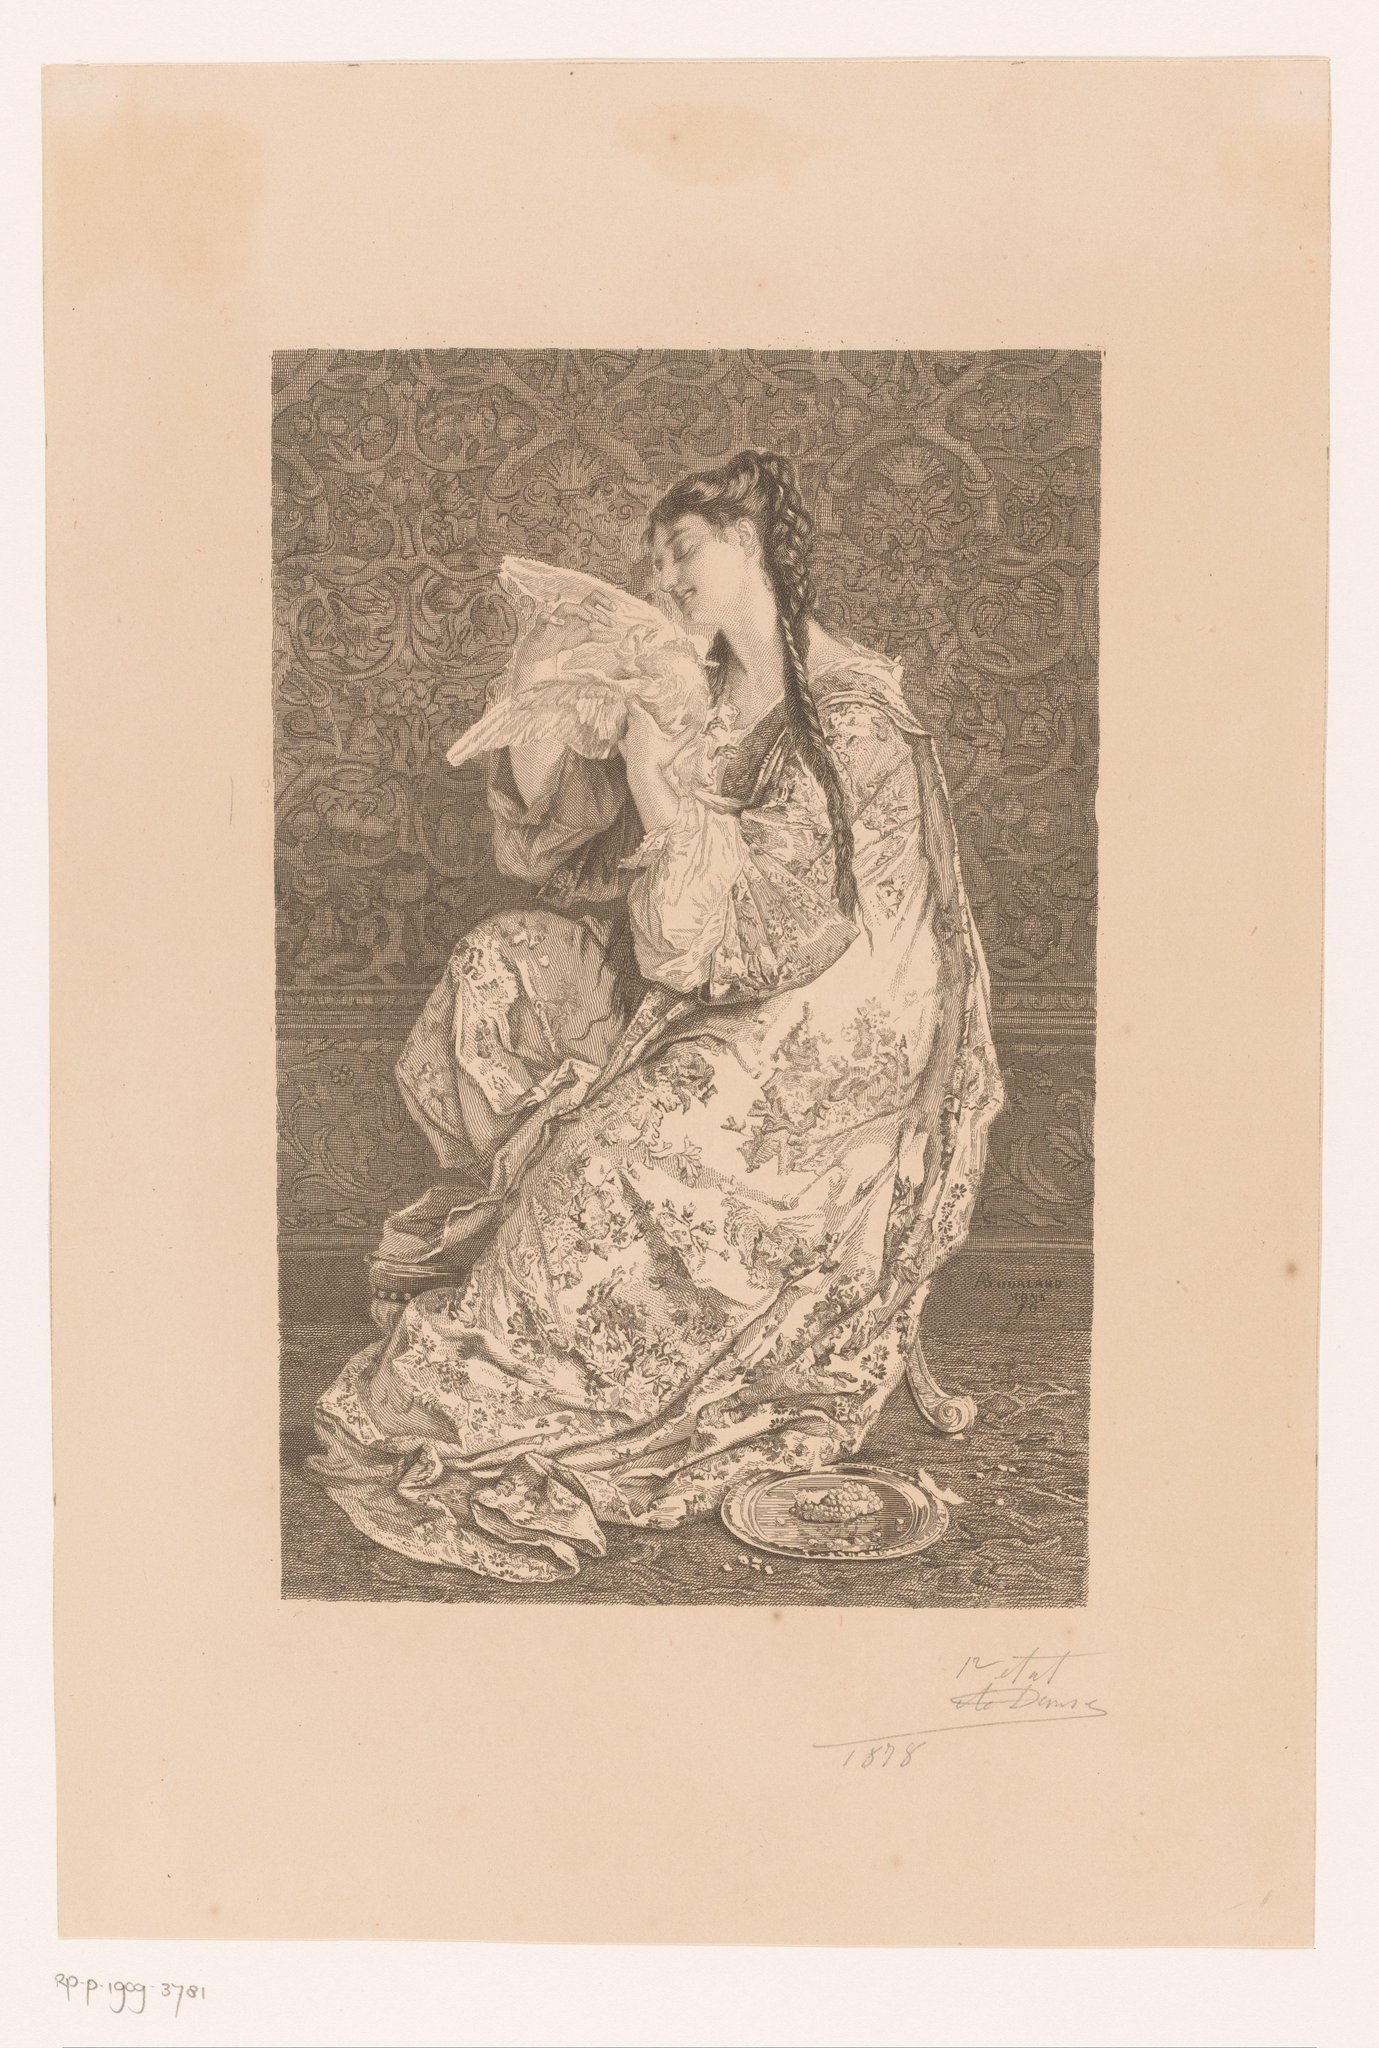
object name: print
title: Jonge vrouw met een duif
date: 1878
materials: paper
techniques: etching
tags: adolescent, young woman, maiden, doves, pigeons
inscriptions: annotation: ‘1er état’, collector's mark: Lugt 2228